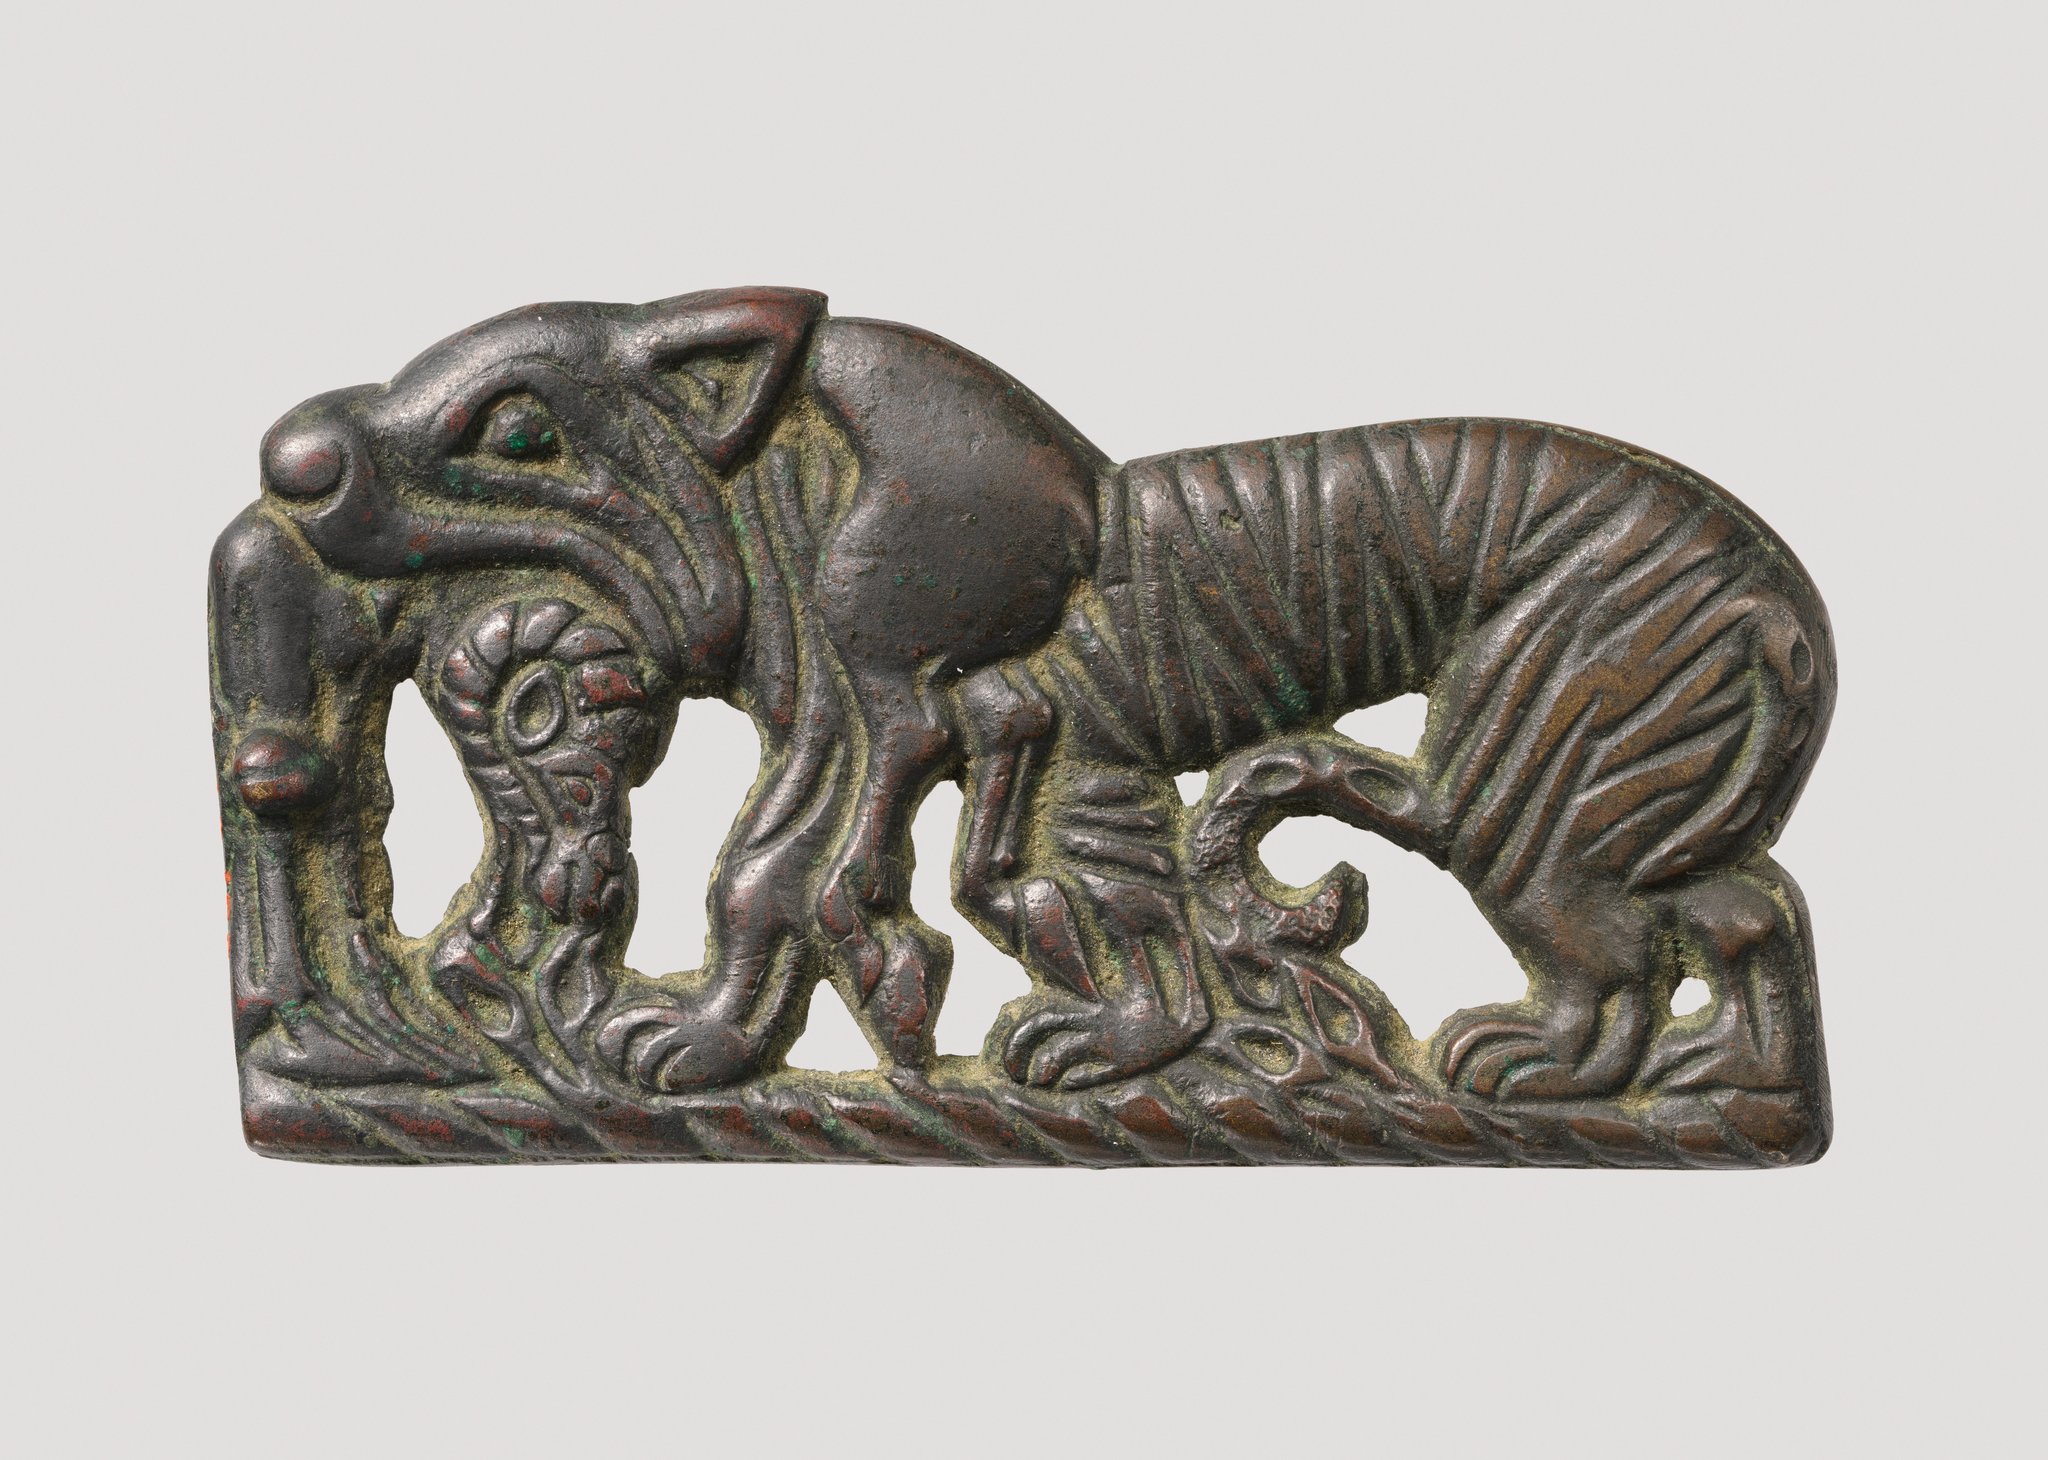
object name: relief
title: Plaque with tiger devouring ram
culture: xiongnu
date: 200-101 BCE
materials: bronze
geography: eurasian steppes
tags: rams,tigers